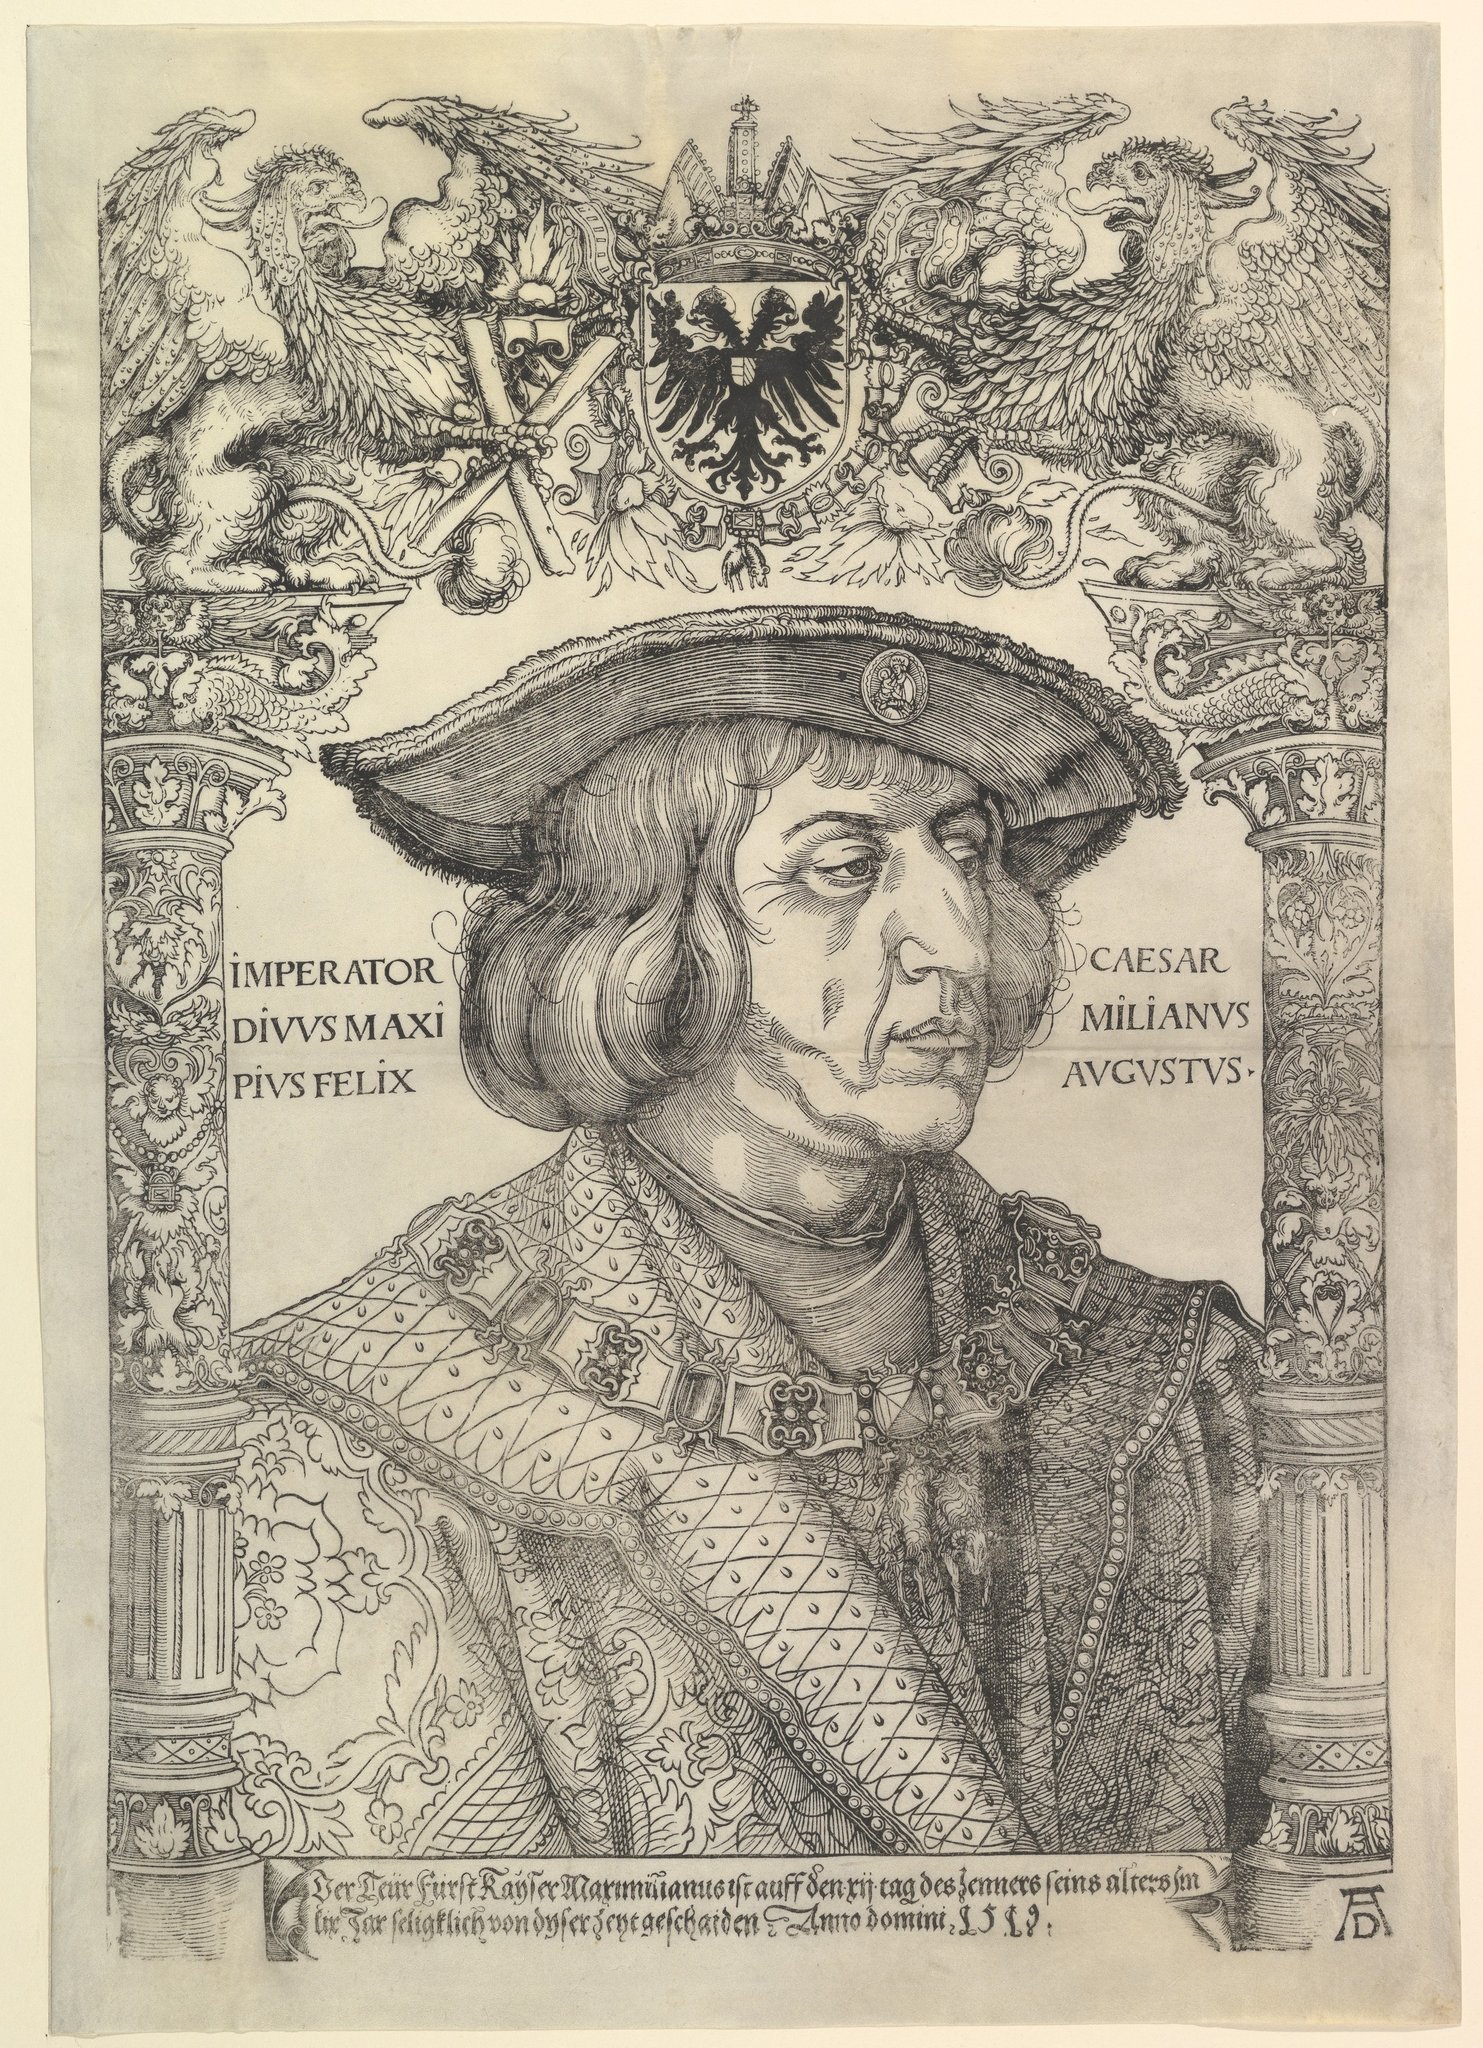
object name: print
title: Portrait of the Emperor Maximilian I in an Architectural Frame (copy)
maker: hans weiditz the younger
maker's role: artist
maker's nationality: german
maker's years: 1500-1536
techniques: woodcut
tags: men,portraits,coat of arms